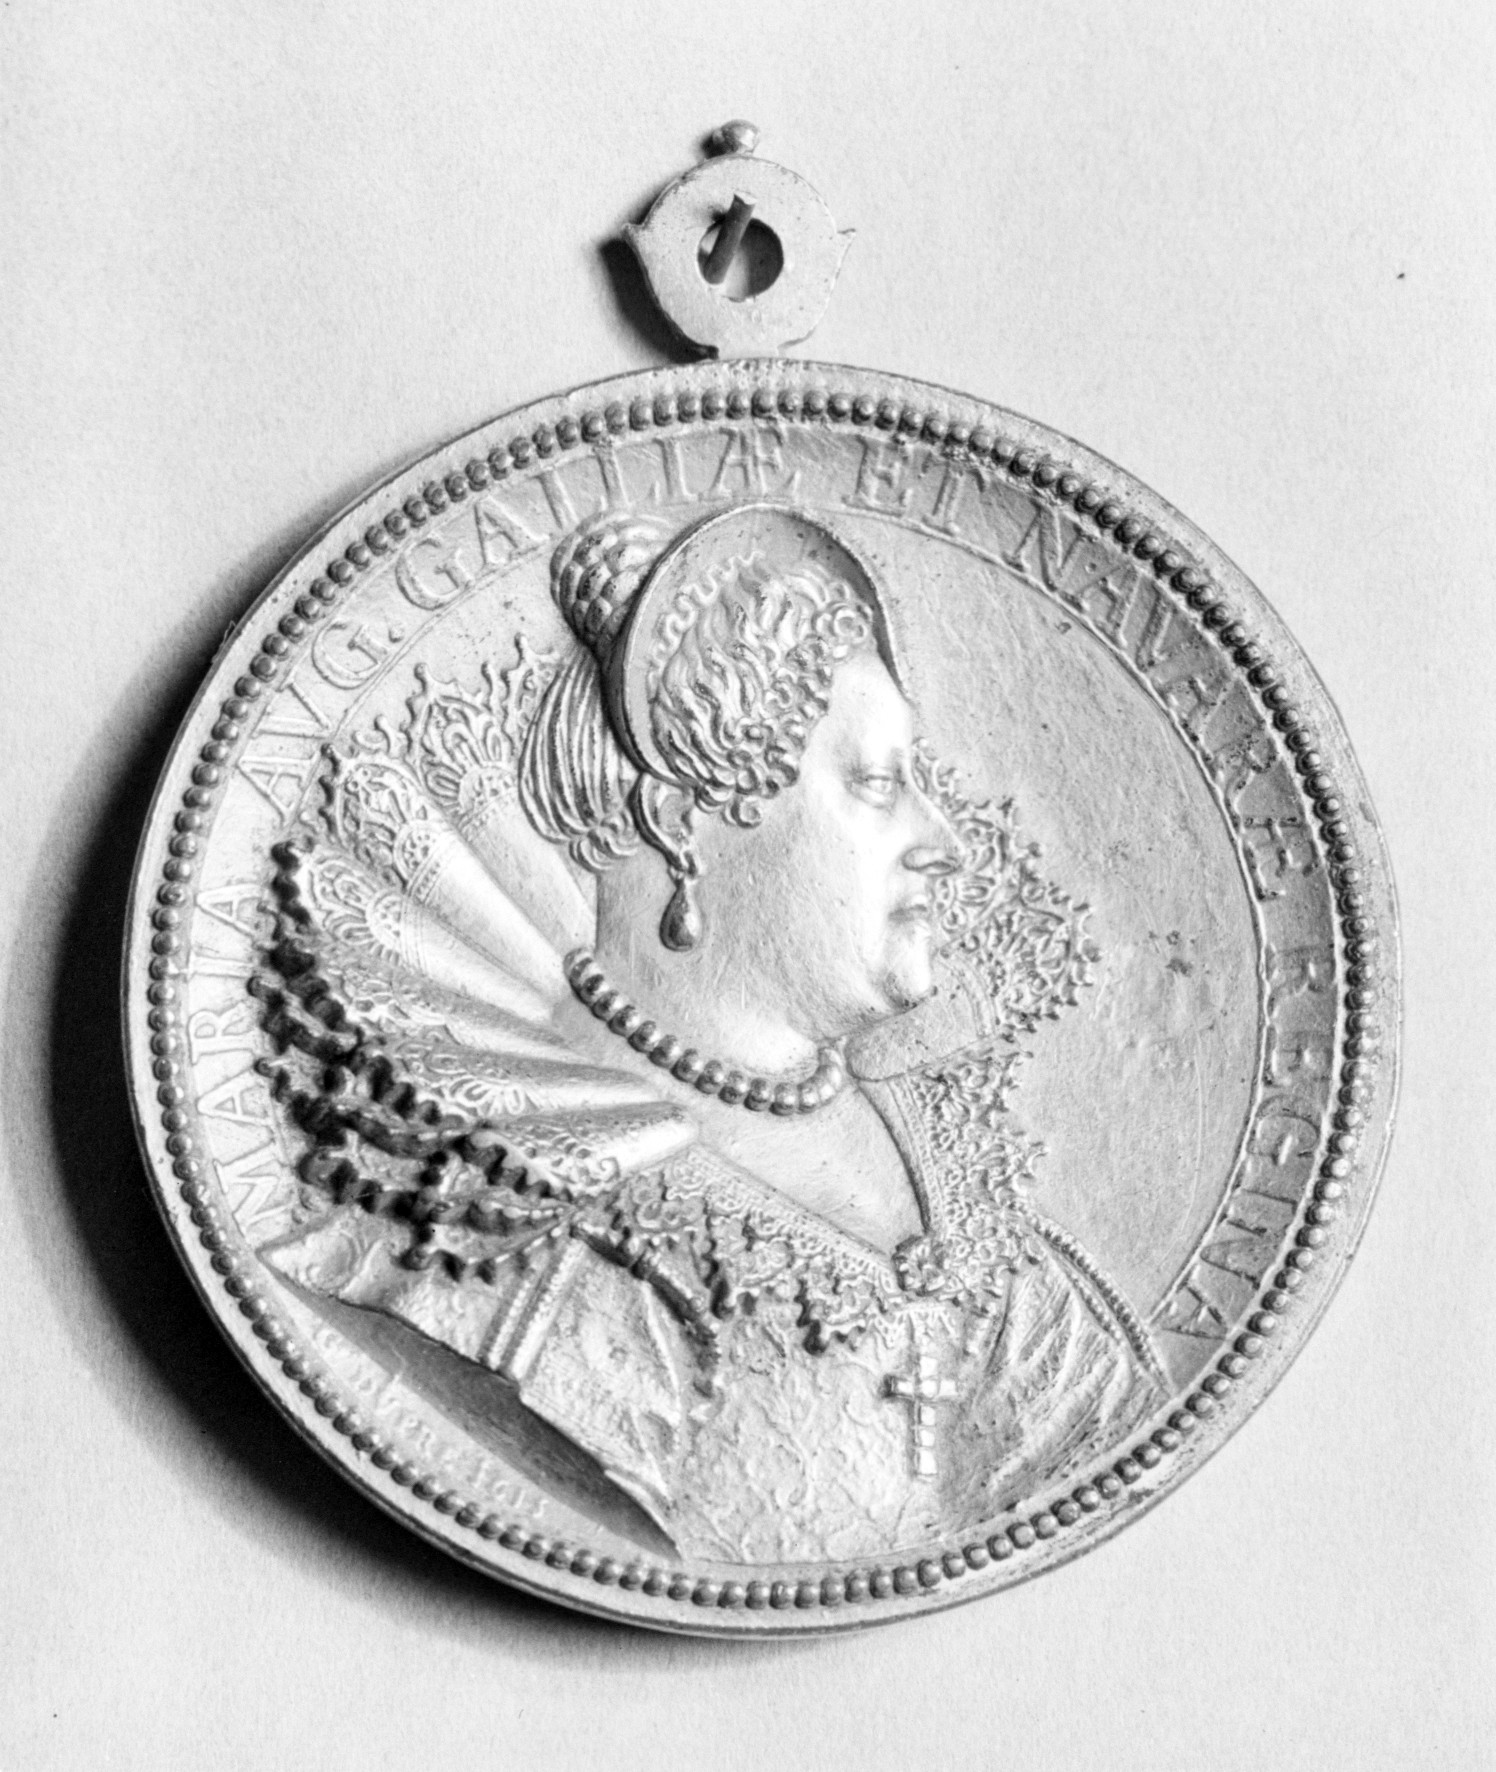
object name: medal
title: Marie de Médicis (1573–1610)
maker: guillaume dupré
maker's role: artist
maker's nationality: french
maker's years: 1579-1640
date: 1615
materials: gilt bronze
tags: profiles,women